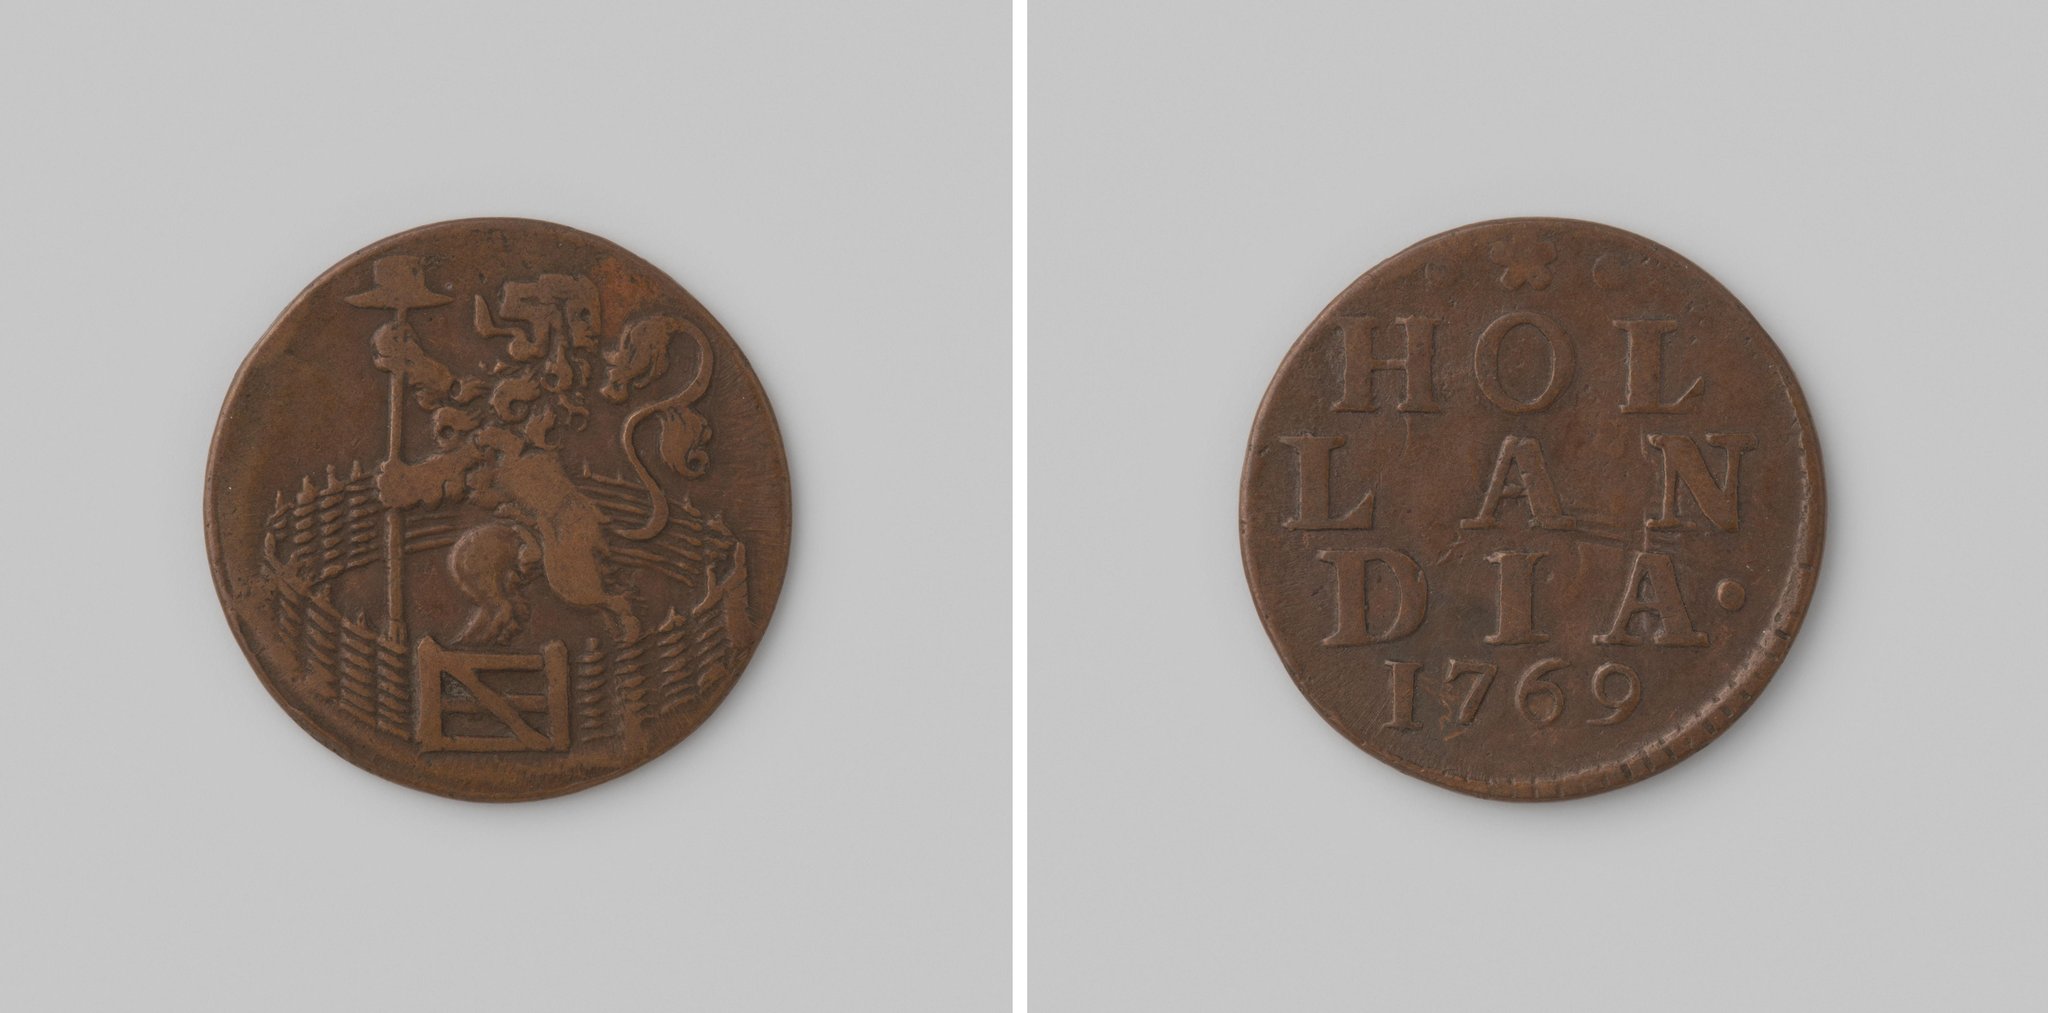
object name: coin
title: Holland, duit, 1769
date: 1769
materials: copper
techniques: striking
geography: dordrecht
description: Koperen munt. Voorzijde: binnen omheining staande leeuw met vrijheidshoed op speer. Keerzijde: opschrift: provincienaam in drie regels, daaronder jaartal.